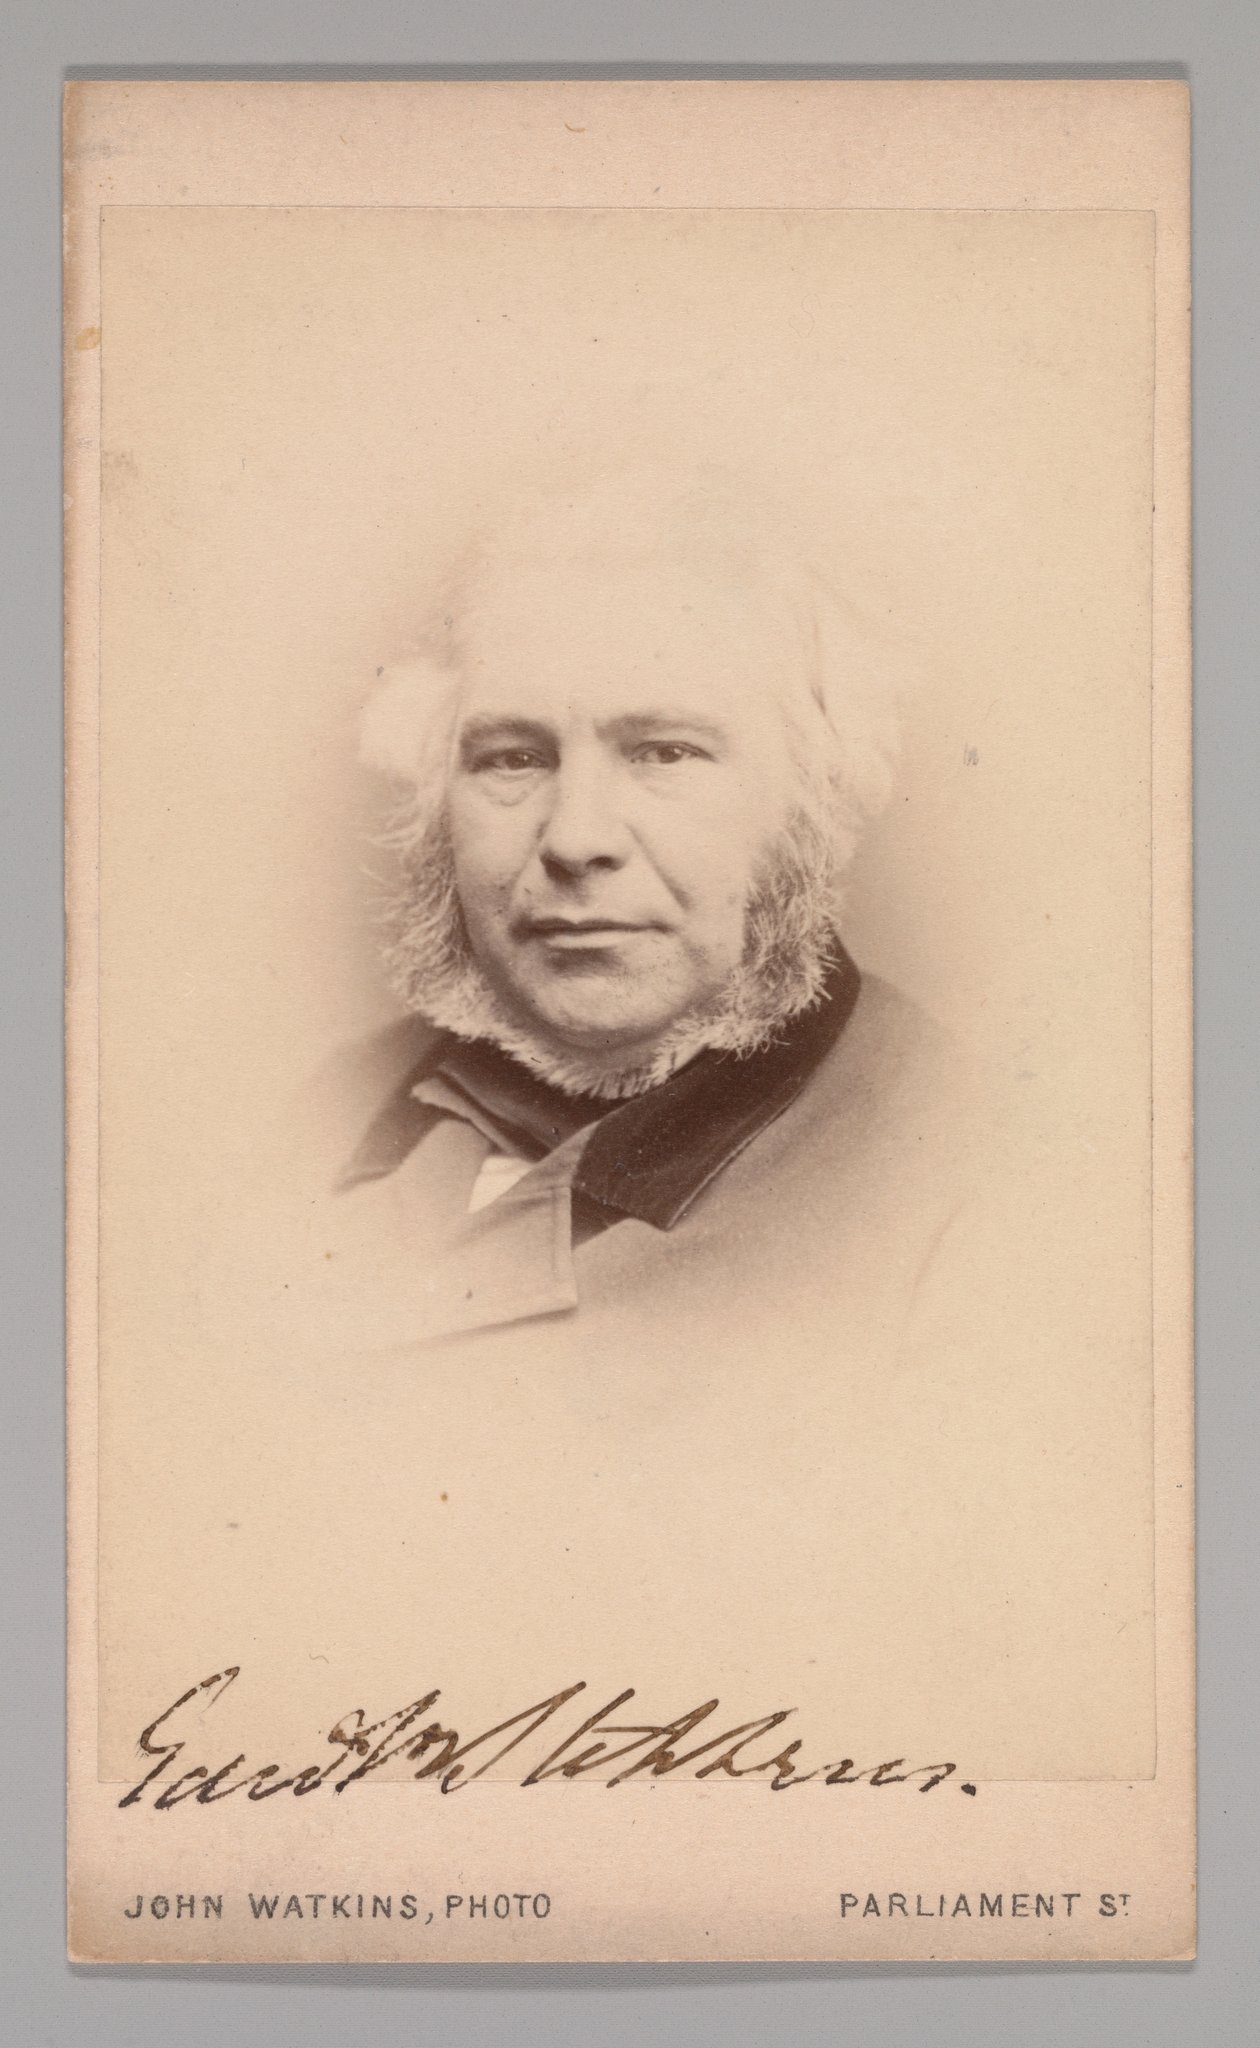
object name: carte de visite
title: [Unknown Subject]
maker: john and charles watkins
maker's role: photography studio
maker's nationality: british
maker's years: 1840-1875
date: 1860-1869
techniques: albumen silver print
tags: men,portraits